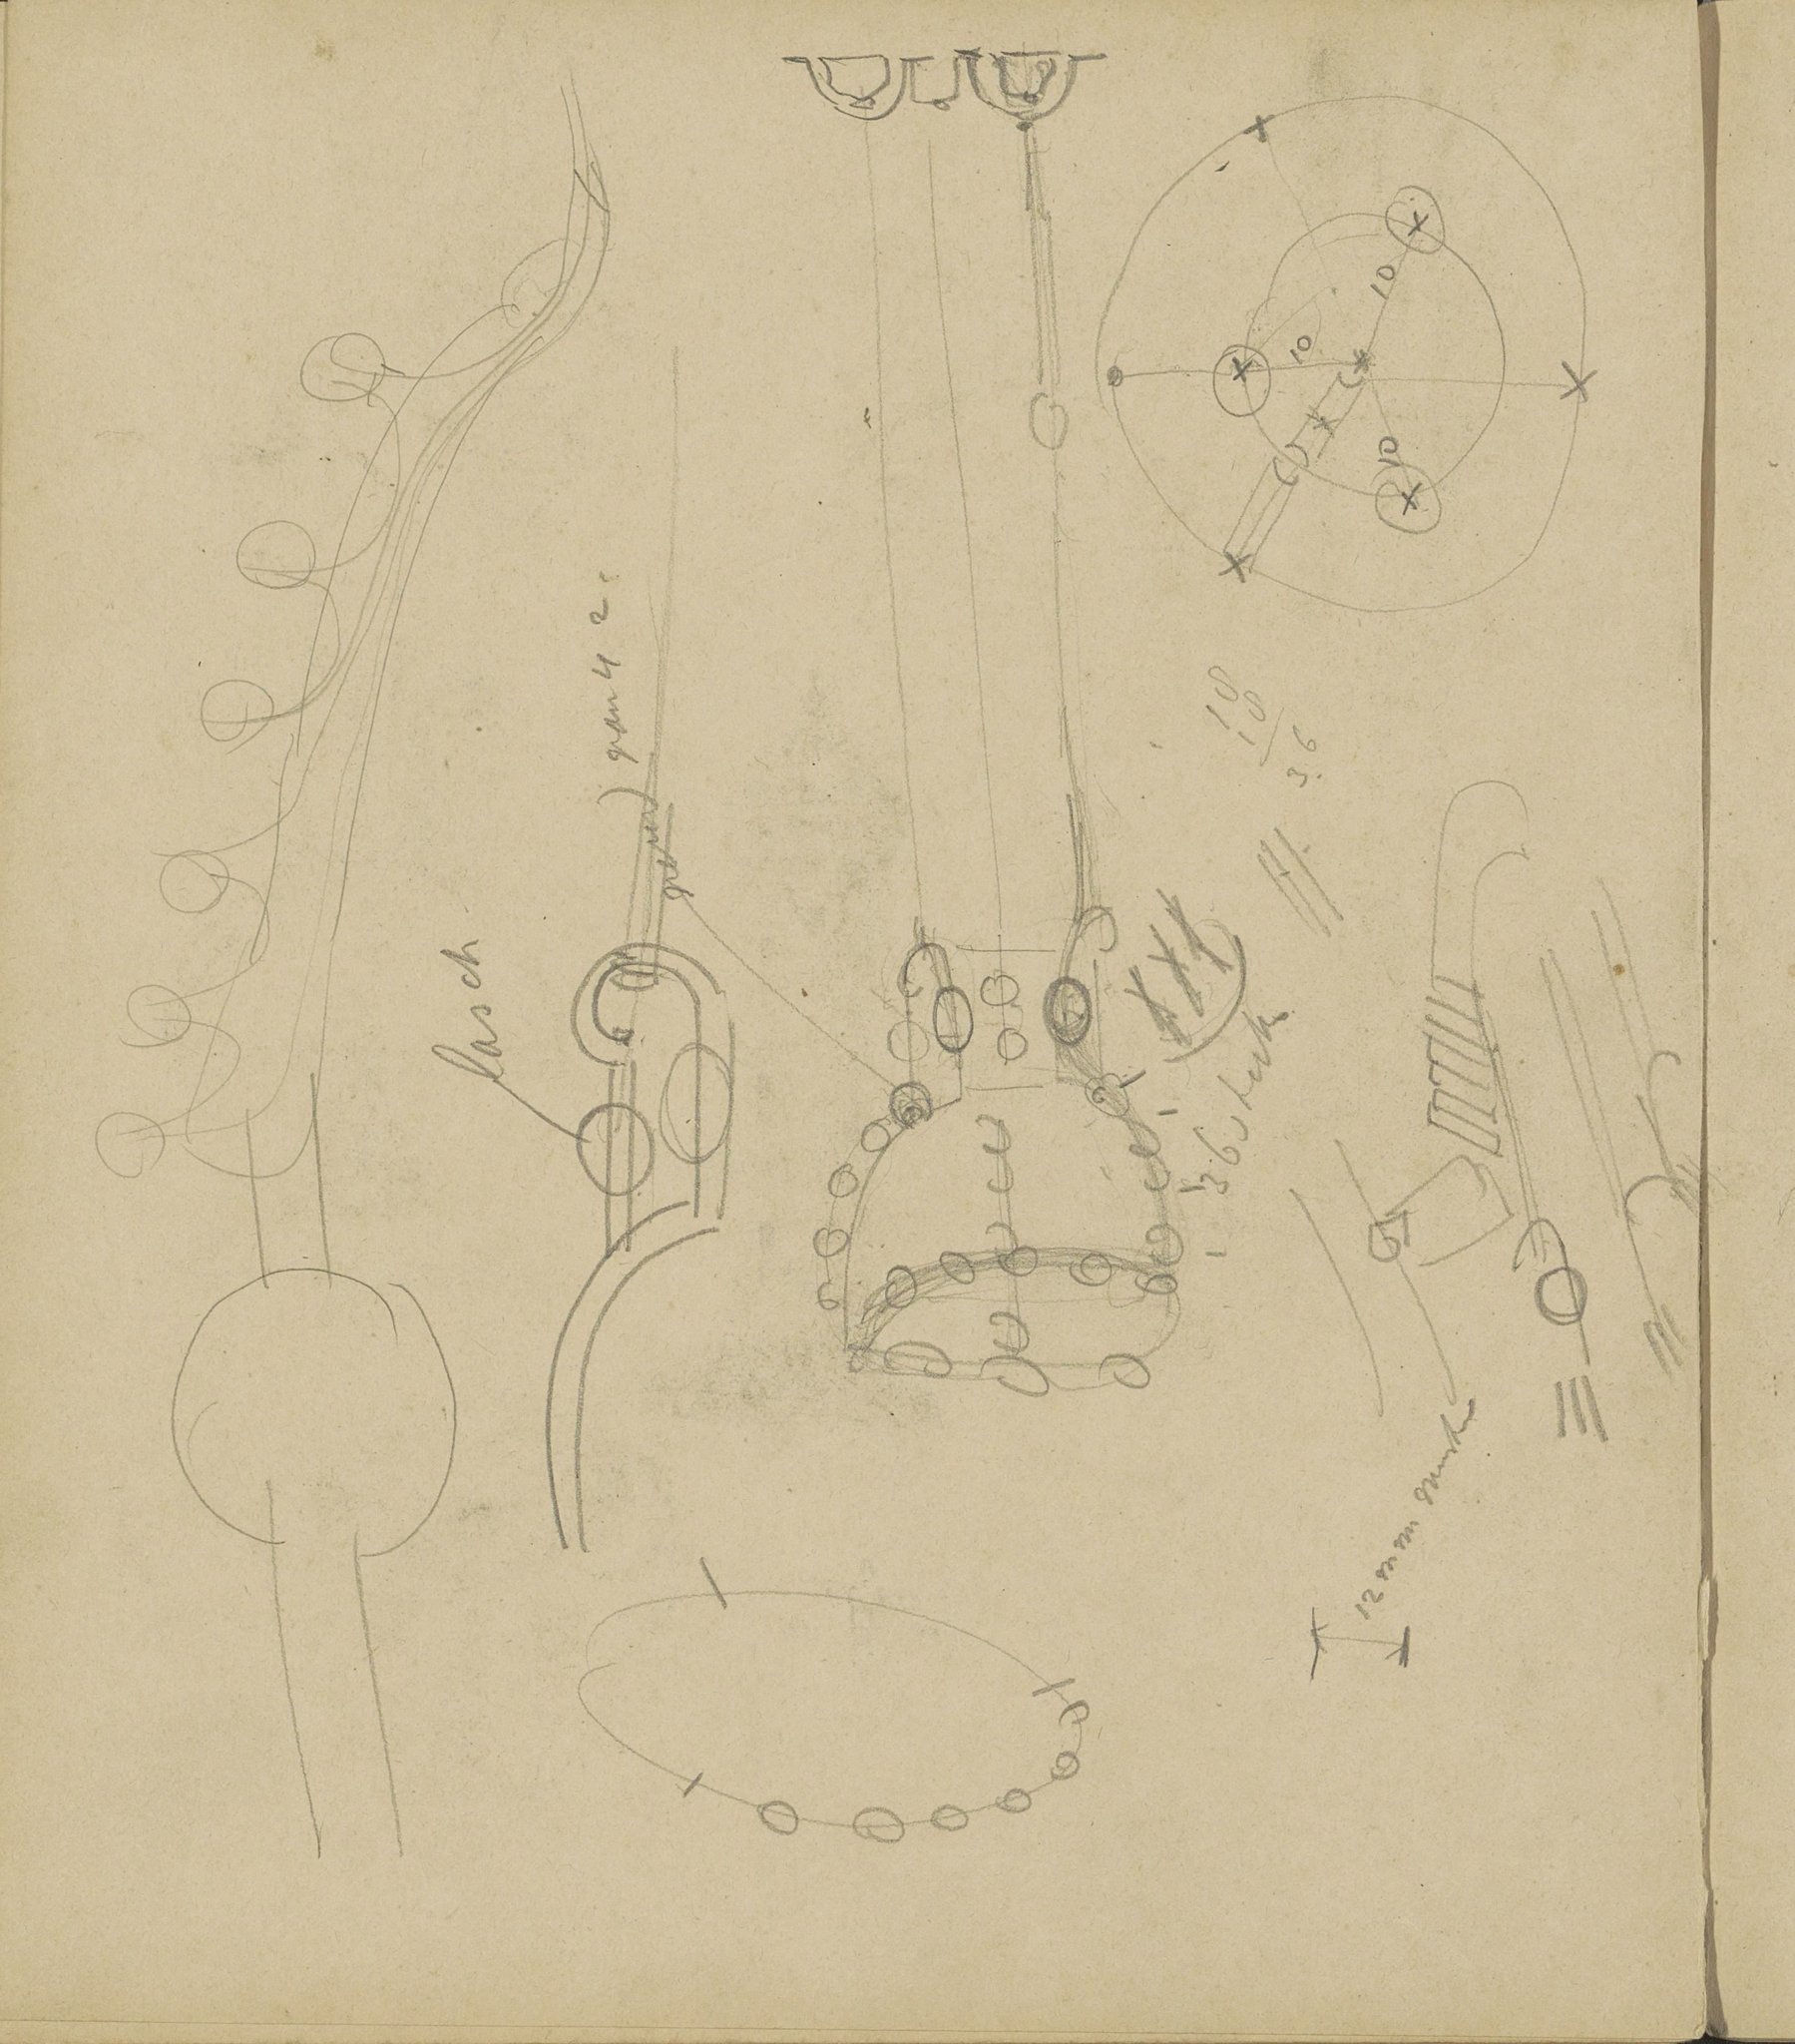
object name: sketchbook leaf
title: Ontwerpen voor hanglampen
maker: carel adolph lion cachet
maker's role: draughtsman, print maker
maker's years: 1864-1945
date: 1905-1906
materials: paper, pencil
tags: lighting; lamps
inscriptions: annotation: ‘[...]’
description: Blad 17 verso uit een schetsboek met 30 bladen.